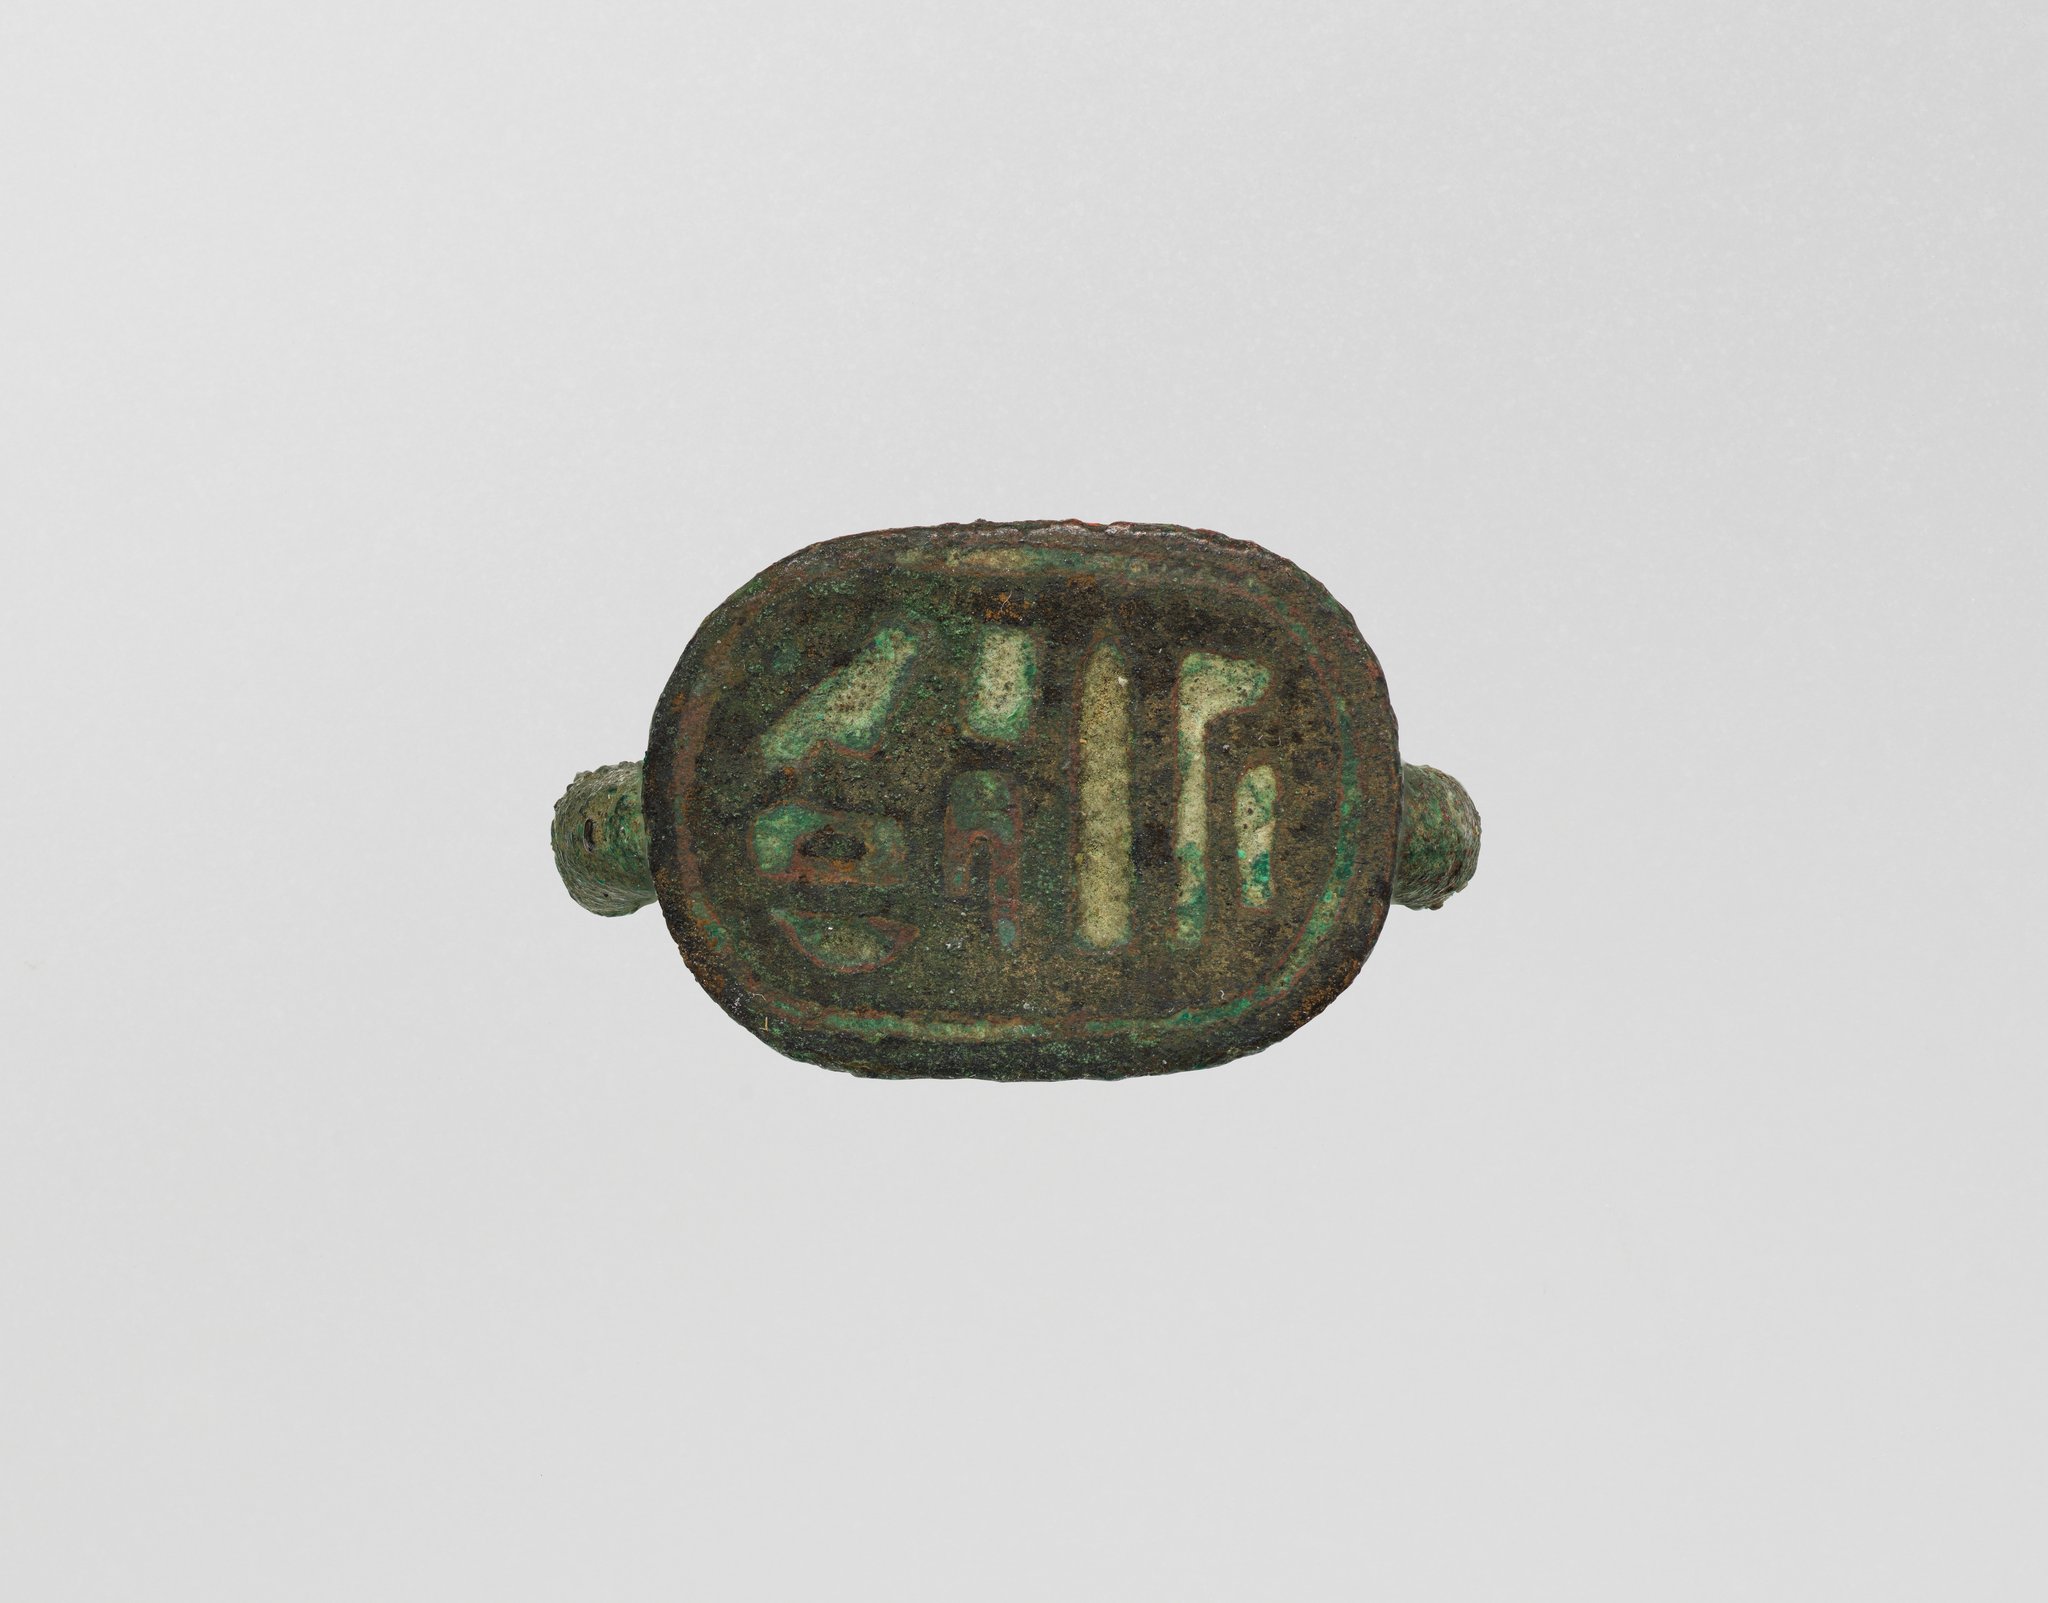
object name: ring, signet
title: Signet ring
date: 1070-712 BCE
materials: faience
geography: egypt